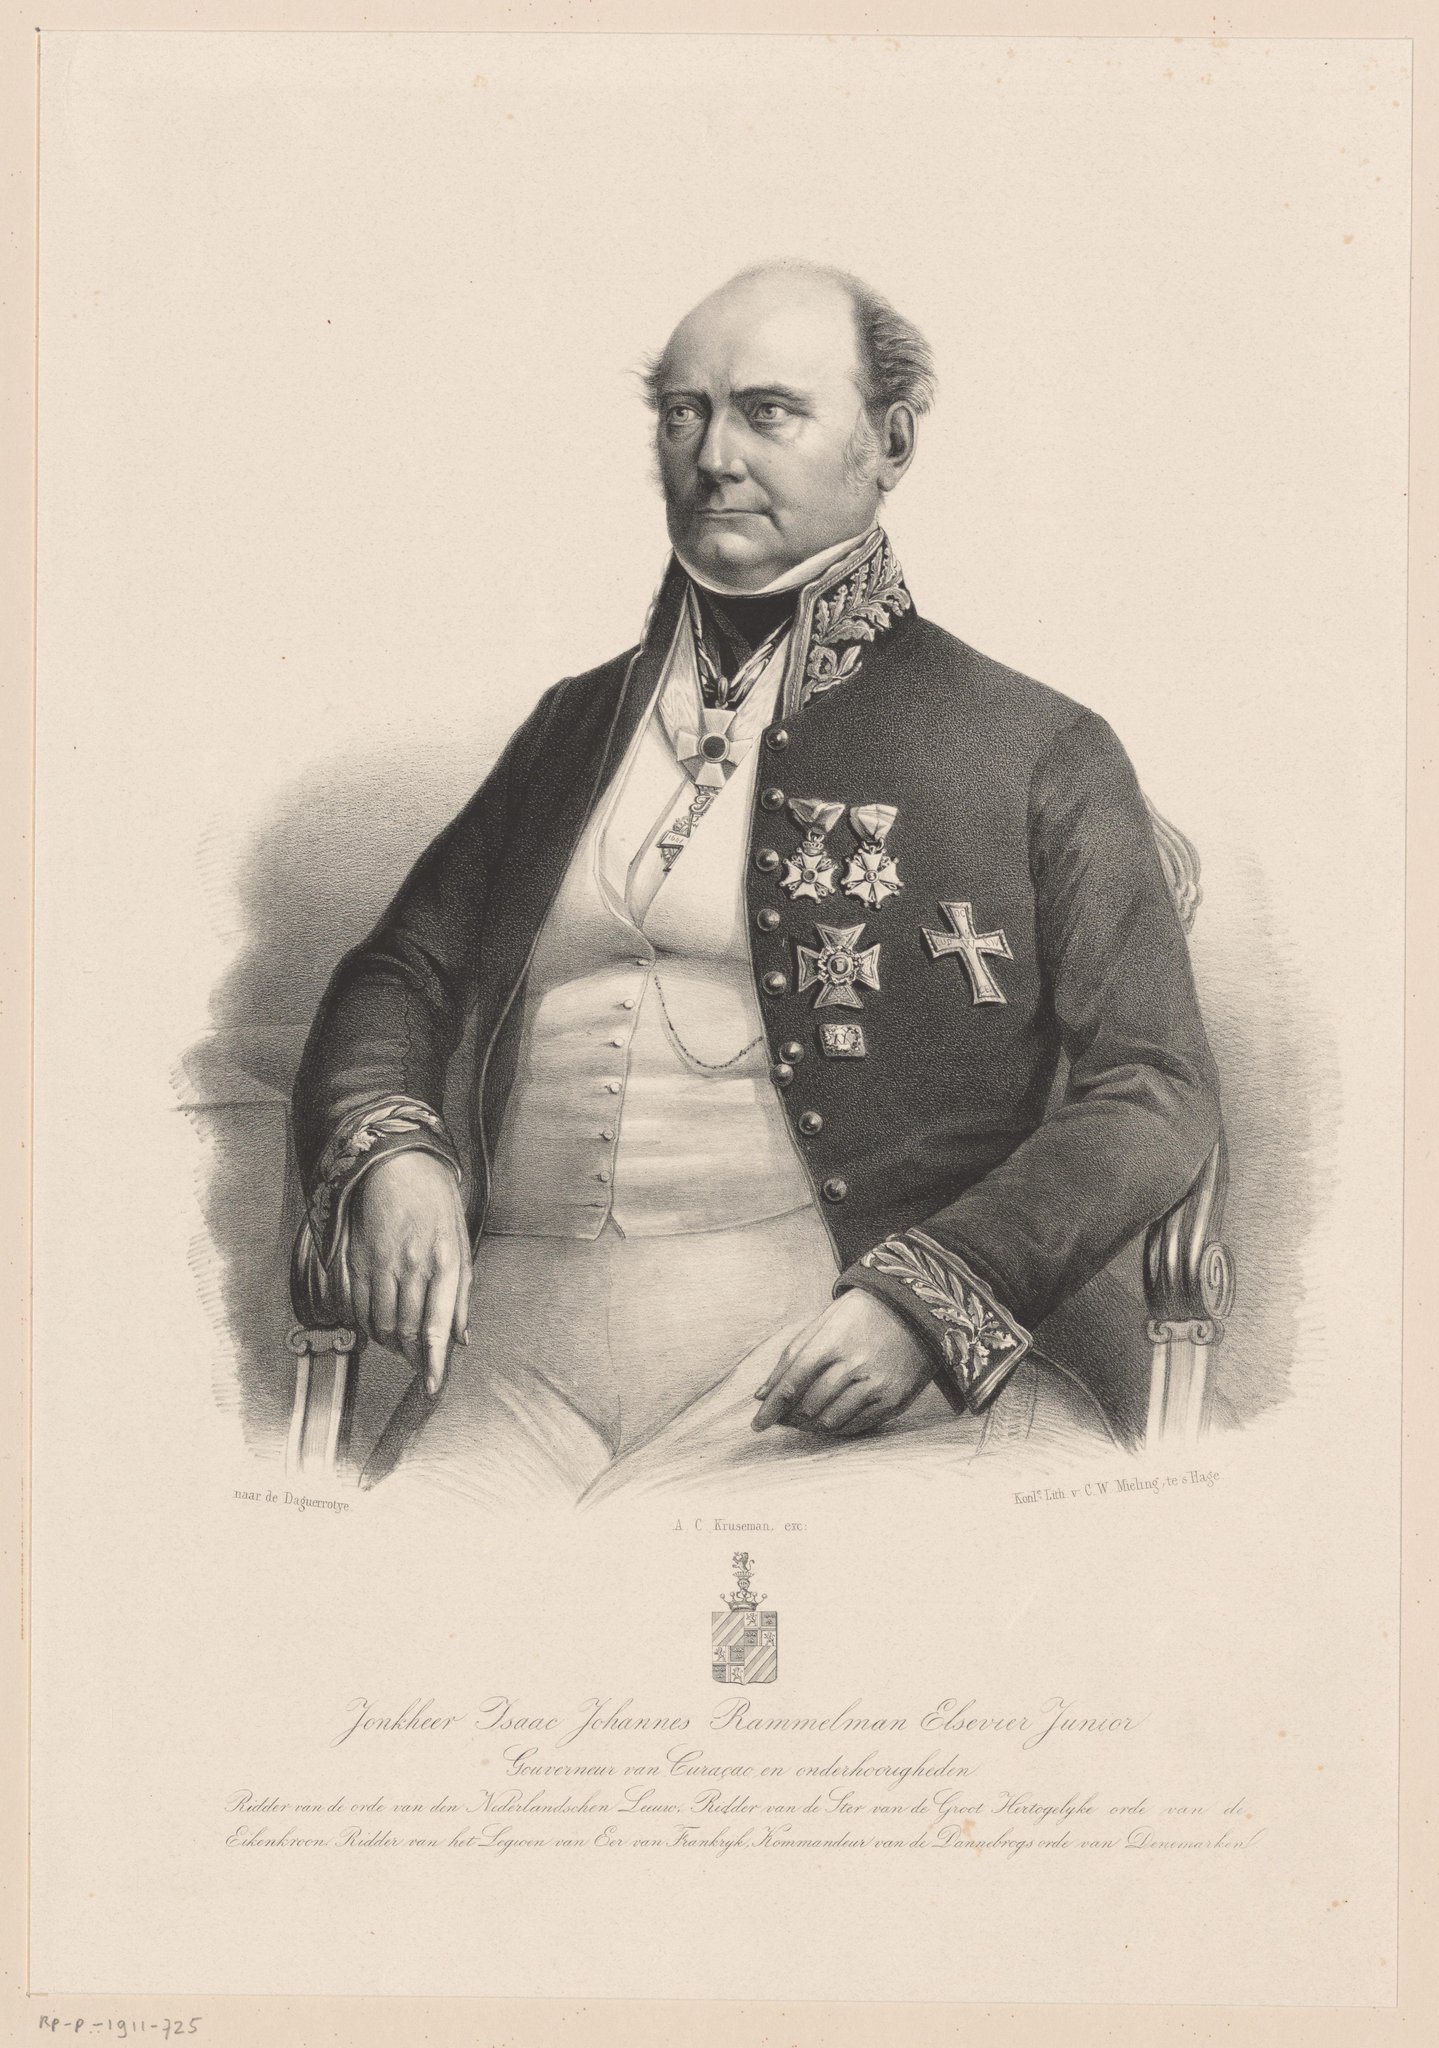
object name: print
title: Portret van Isaäc Rammelman Elsevier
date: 1849-1854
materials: paper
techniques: lithograph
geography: the hague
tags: amsterdam, colonial governor, historical persons, armorial bearing, heraldry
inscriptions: collector's mark: Lugt 2228